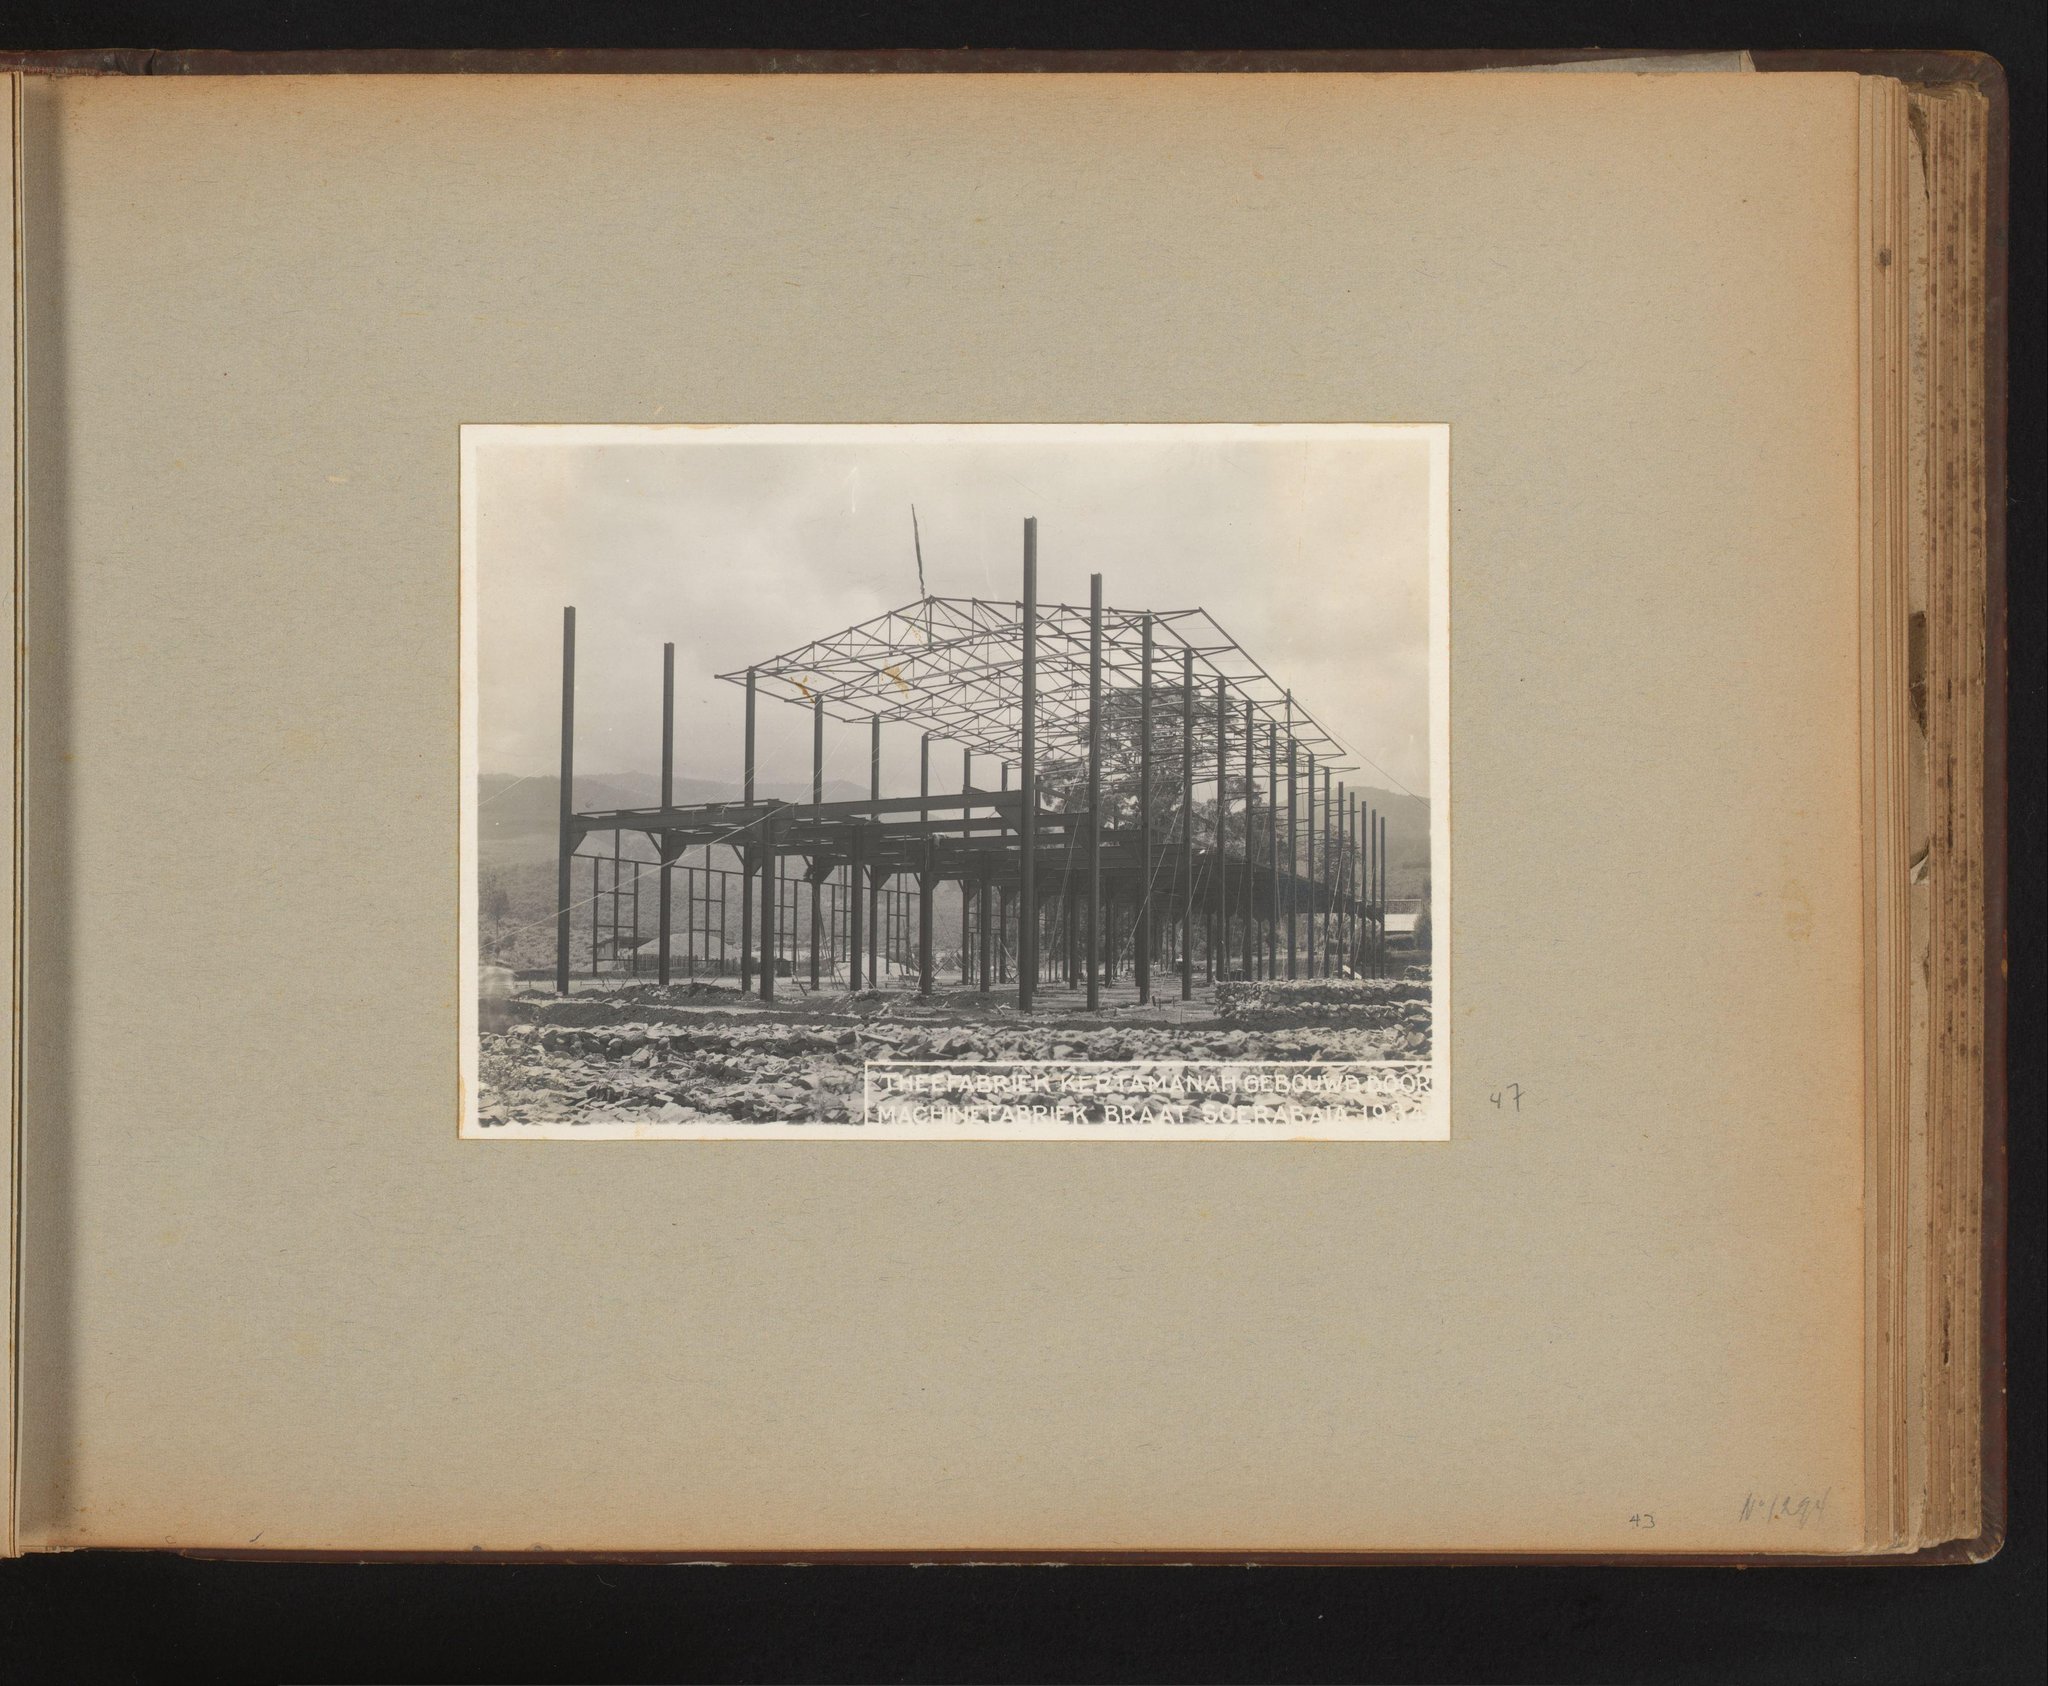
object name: photograph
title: Theefabriek Kertamanah gebouwd door Machinefabriek Braat Soerabaia 1934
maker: Anonymous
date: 1934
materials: cardboard, photographic support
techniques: gelatin silver print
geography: bandung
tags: factory-building, making the overground structures (~ building activities), java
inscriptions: date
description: Albumblad met een foto van de theefabriek Kertamanah ten zuiden van Bandoeng, in aanbouw in 1934. Onderdeel van een fotoalbum met foto's van machines en constructies van de N.V. Machinefabriek Braat te Soerabaja, Soekaboemi en Tegal uit de periode 1931-1937.